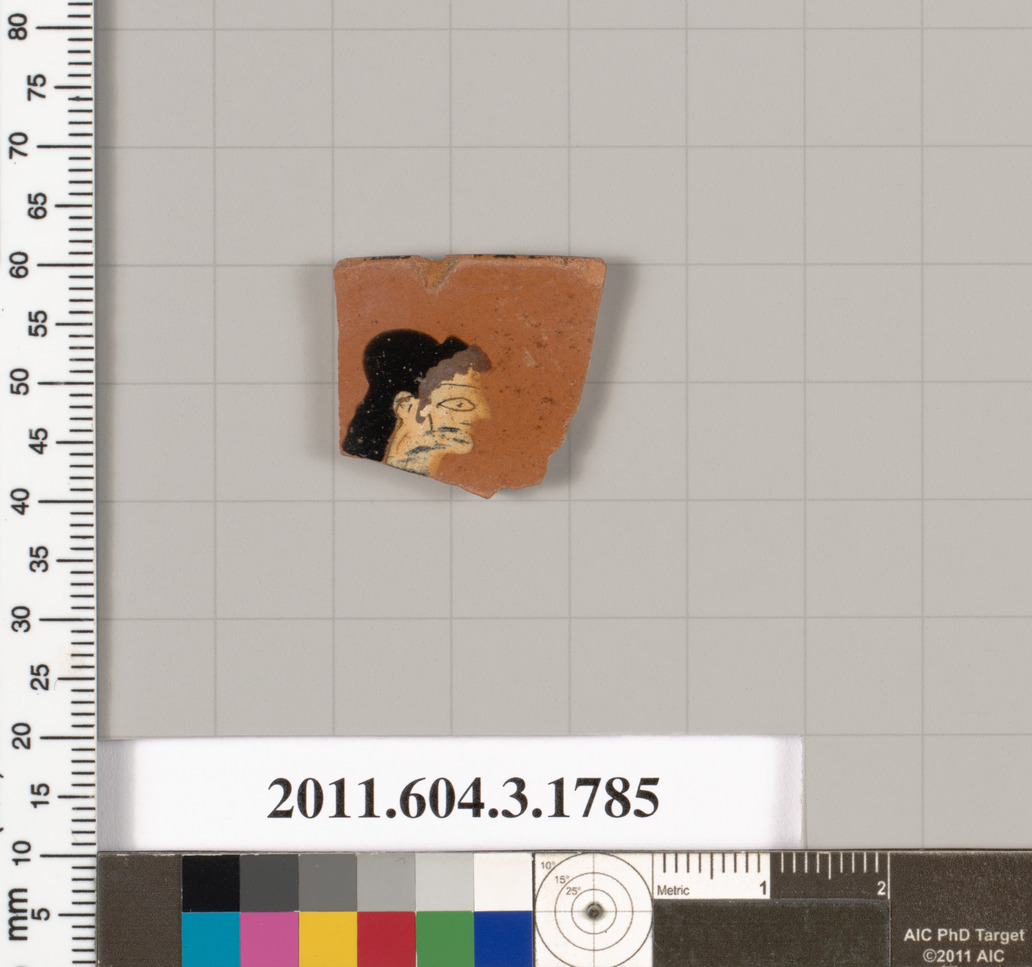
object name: kylix fragment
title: Terracotta rim fragment of a kylix: Lip cup (drinking cup)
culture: greek, attic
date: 550-530 BCE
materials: terracotta